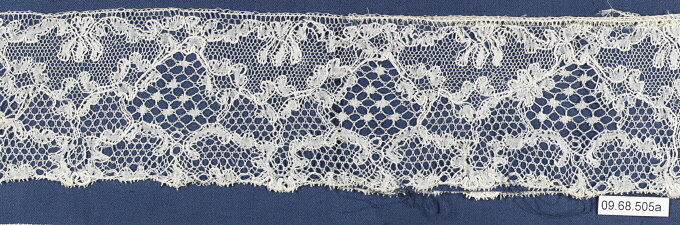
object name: fragment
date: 1801-1900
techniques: lace